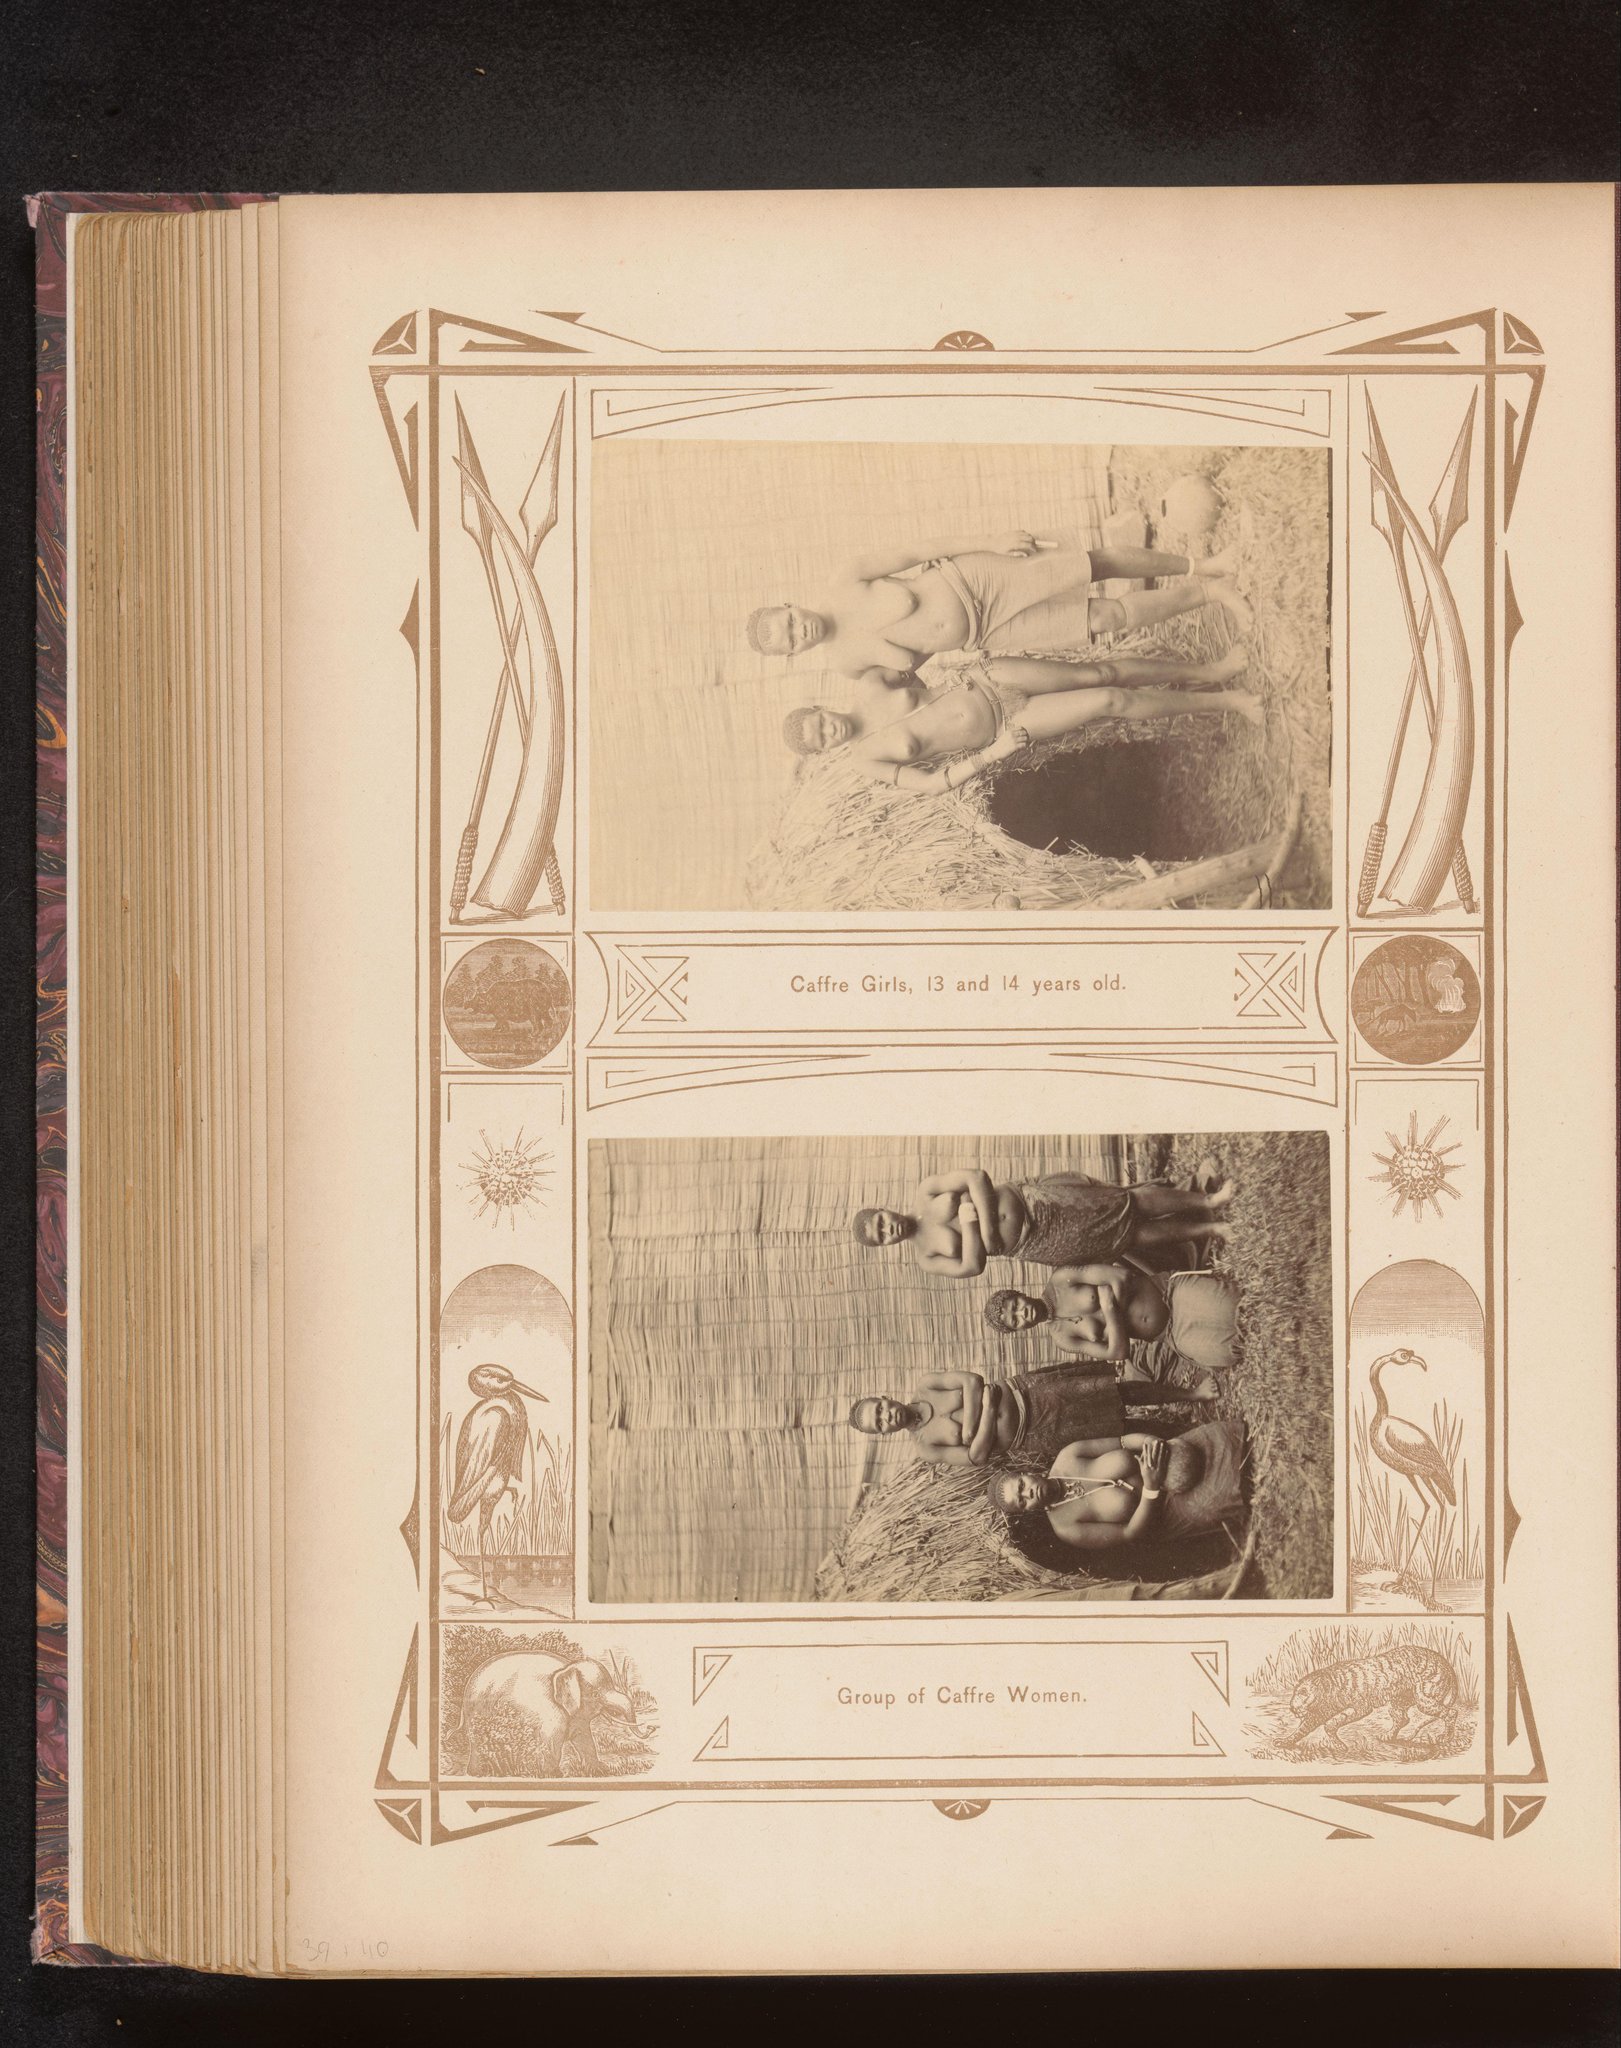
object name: photograph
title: Portret van twee onbekende Afrikaanse jonge vrouwen voor een rieten woning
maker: Anonymous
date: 1877-1882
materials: photographic support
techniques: albumen print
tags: adolescent, young woman, maiden, africans, historical persons, housing